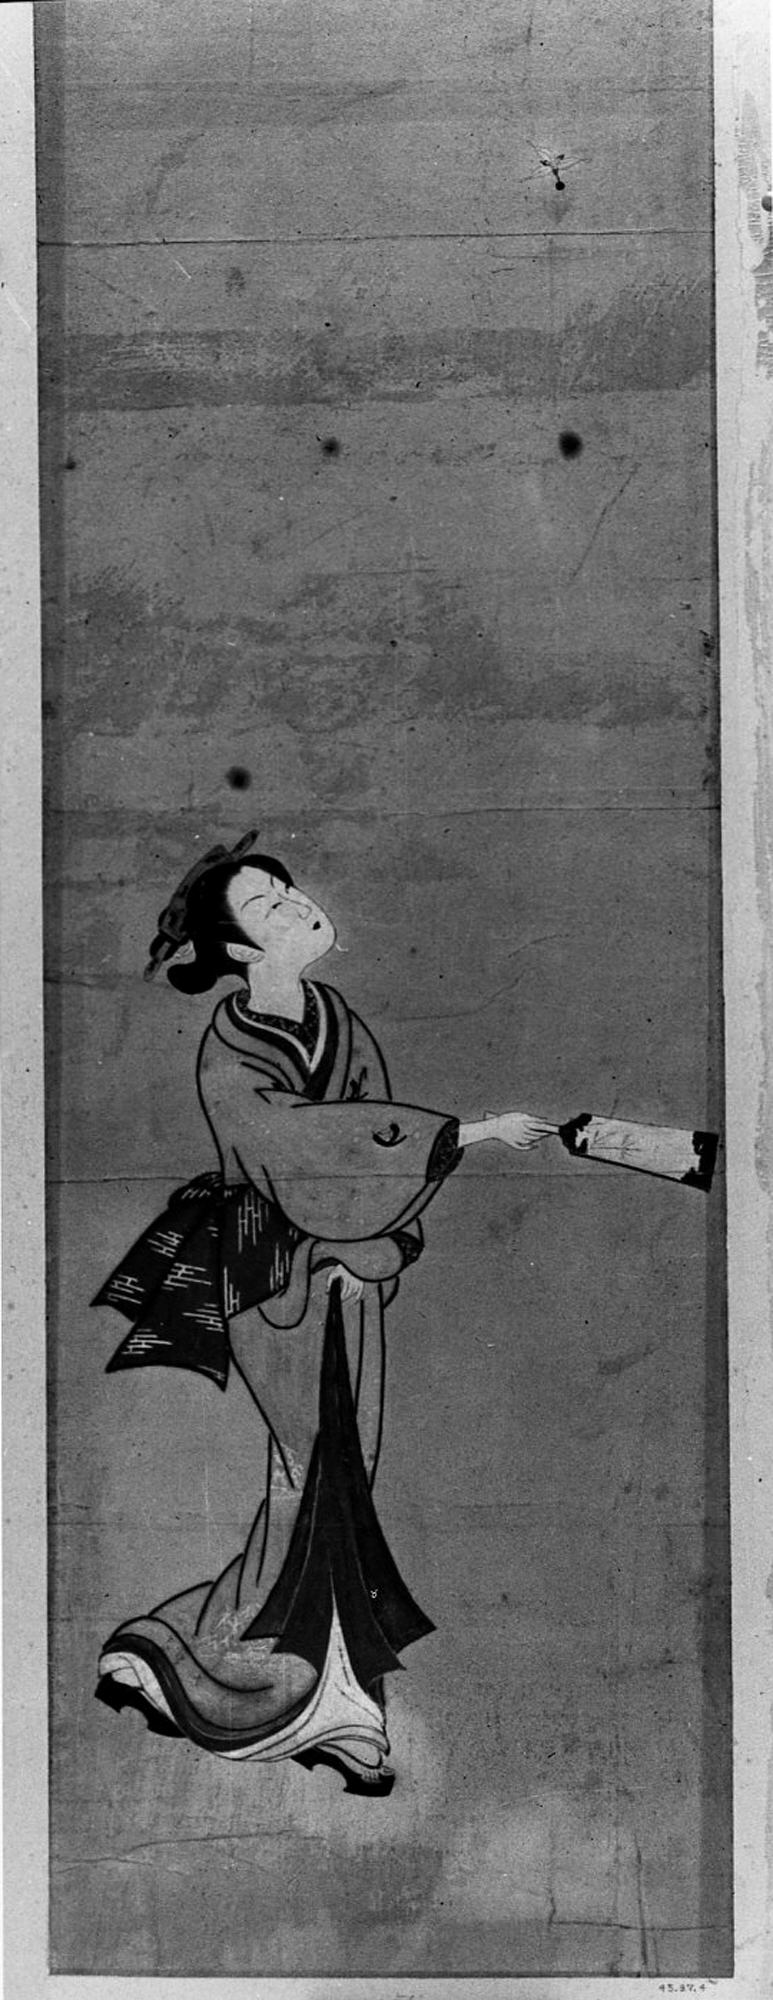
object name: hanging scroll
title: Woman Playing a New Year's Game of Battledore and Shuttlecock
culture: japanese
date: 1701-1800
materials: ink, paper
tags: women,games